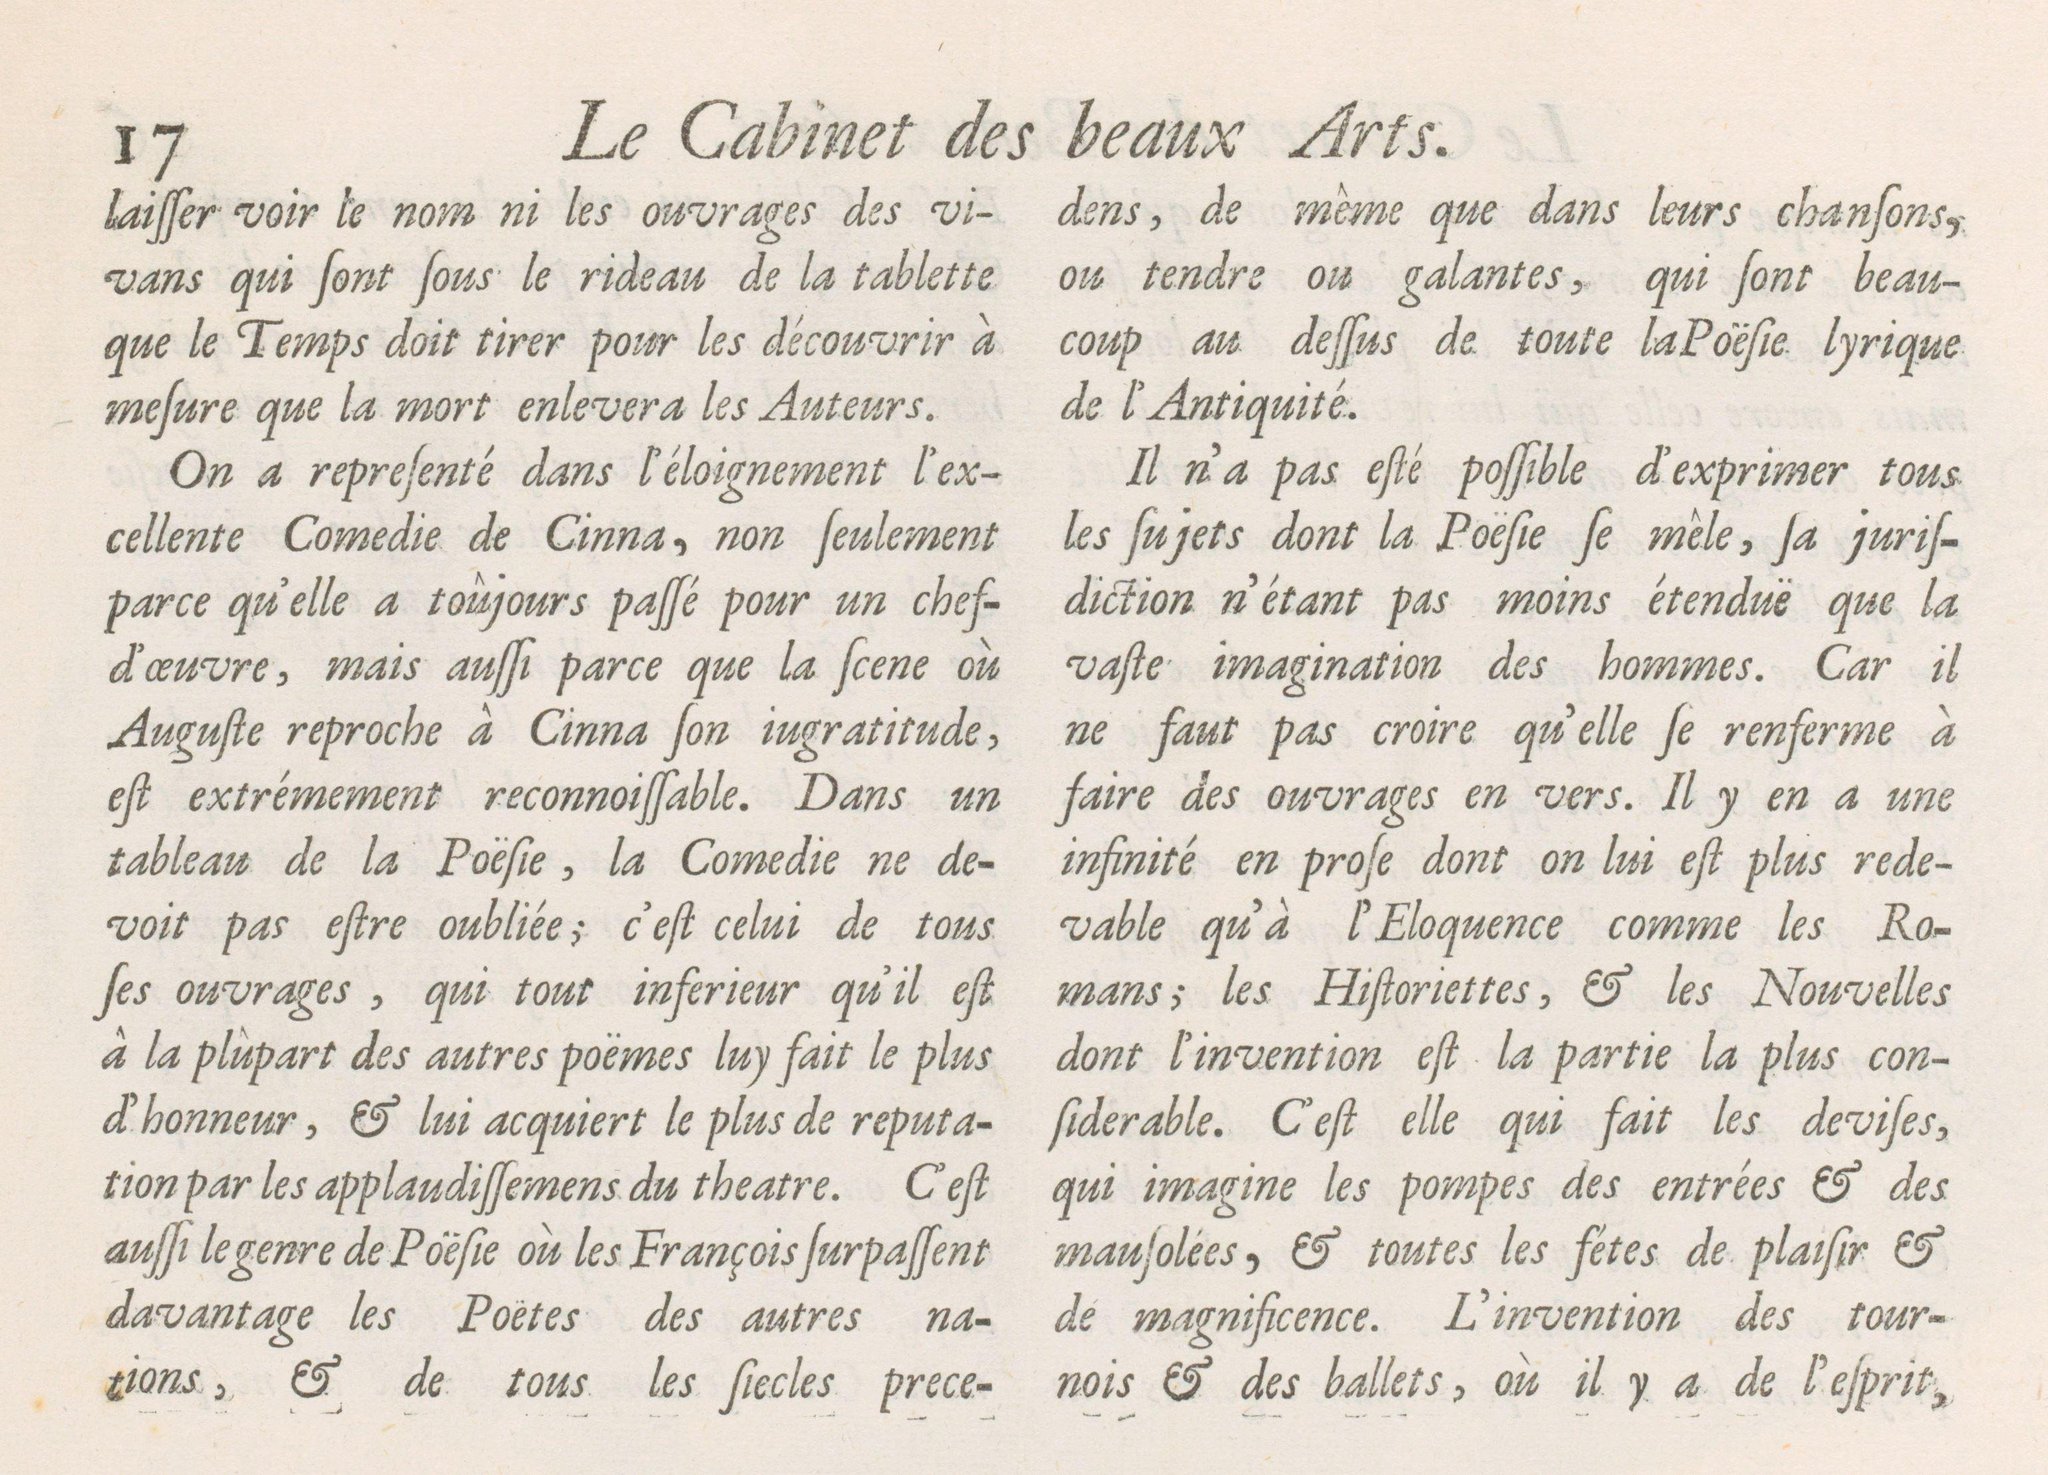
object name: album leaf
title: Tekstblad met verklaring van de prent over Dichtkunst, p. 17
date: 1695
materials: paper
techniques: letterpress printing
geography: paris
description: Verklaring van de prent met voorstelling van Poëzie of Dichtkunst in het Frans. Pagina 17. Tekstblad maakt deel uit van een album.